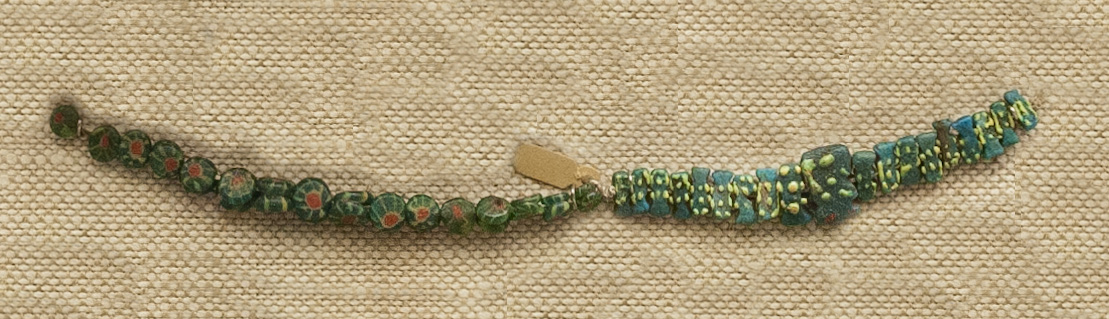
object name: necklace, bead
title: String of 19 "Bes" Beads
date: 332 BCE-364 CE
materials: faience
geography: egypt